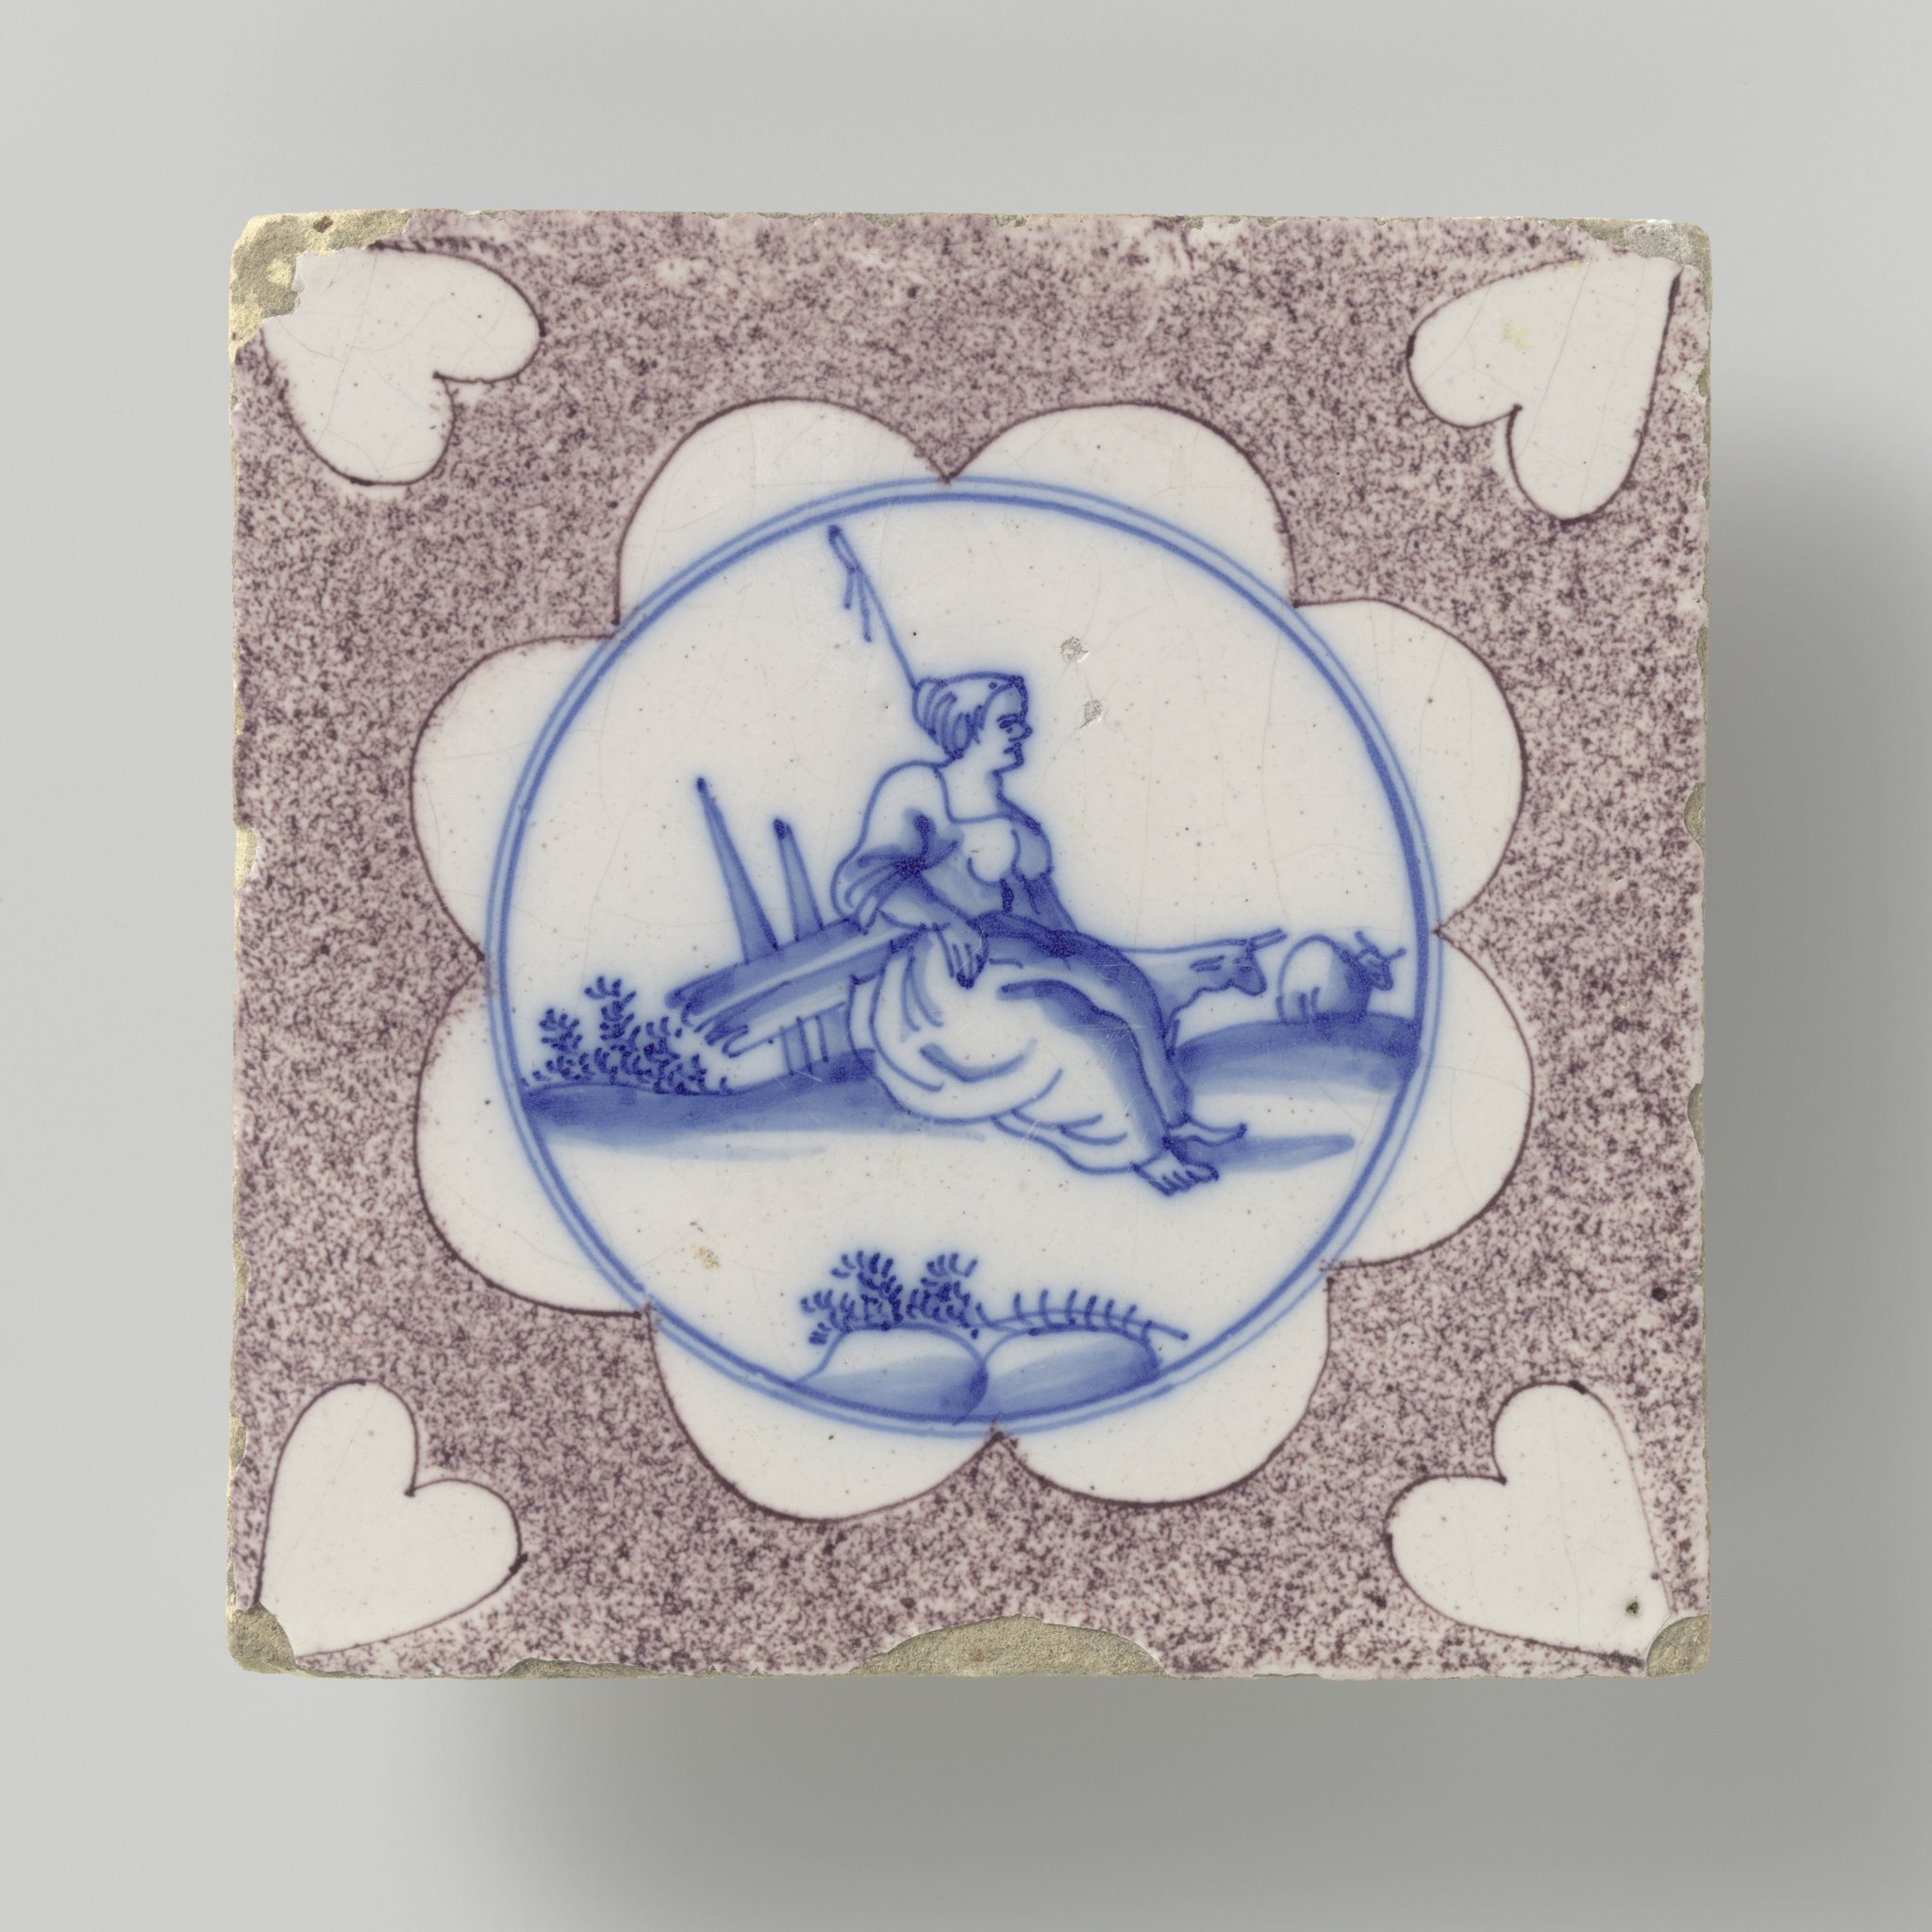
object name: tile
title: Tegel met een blauw geschilderde pastorale voorstelling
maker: Anonymous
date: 1680-1725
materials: earthenware, glaze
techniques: maiolica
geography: netherlands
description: Tegel met een blauw geschilderde pastorale voorstelling binnen een geschulpte cirkel omgeven door paars spatwerk. In de hoeken, een uitgespaarde hartvorm. Behorend bij een groep van 23 tegels.